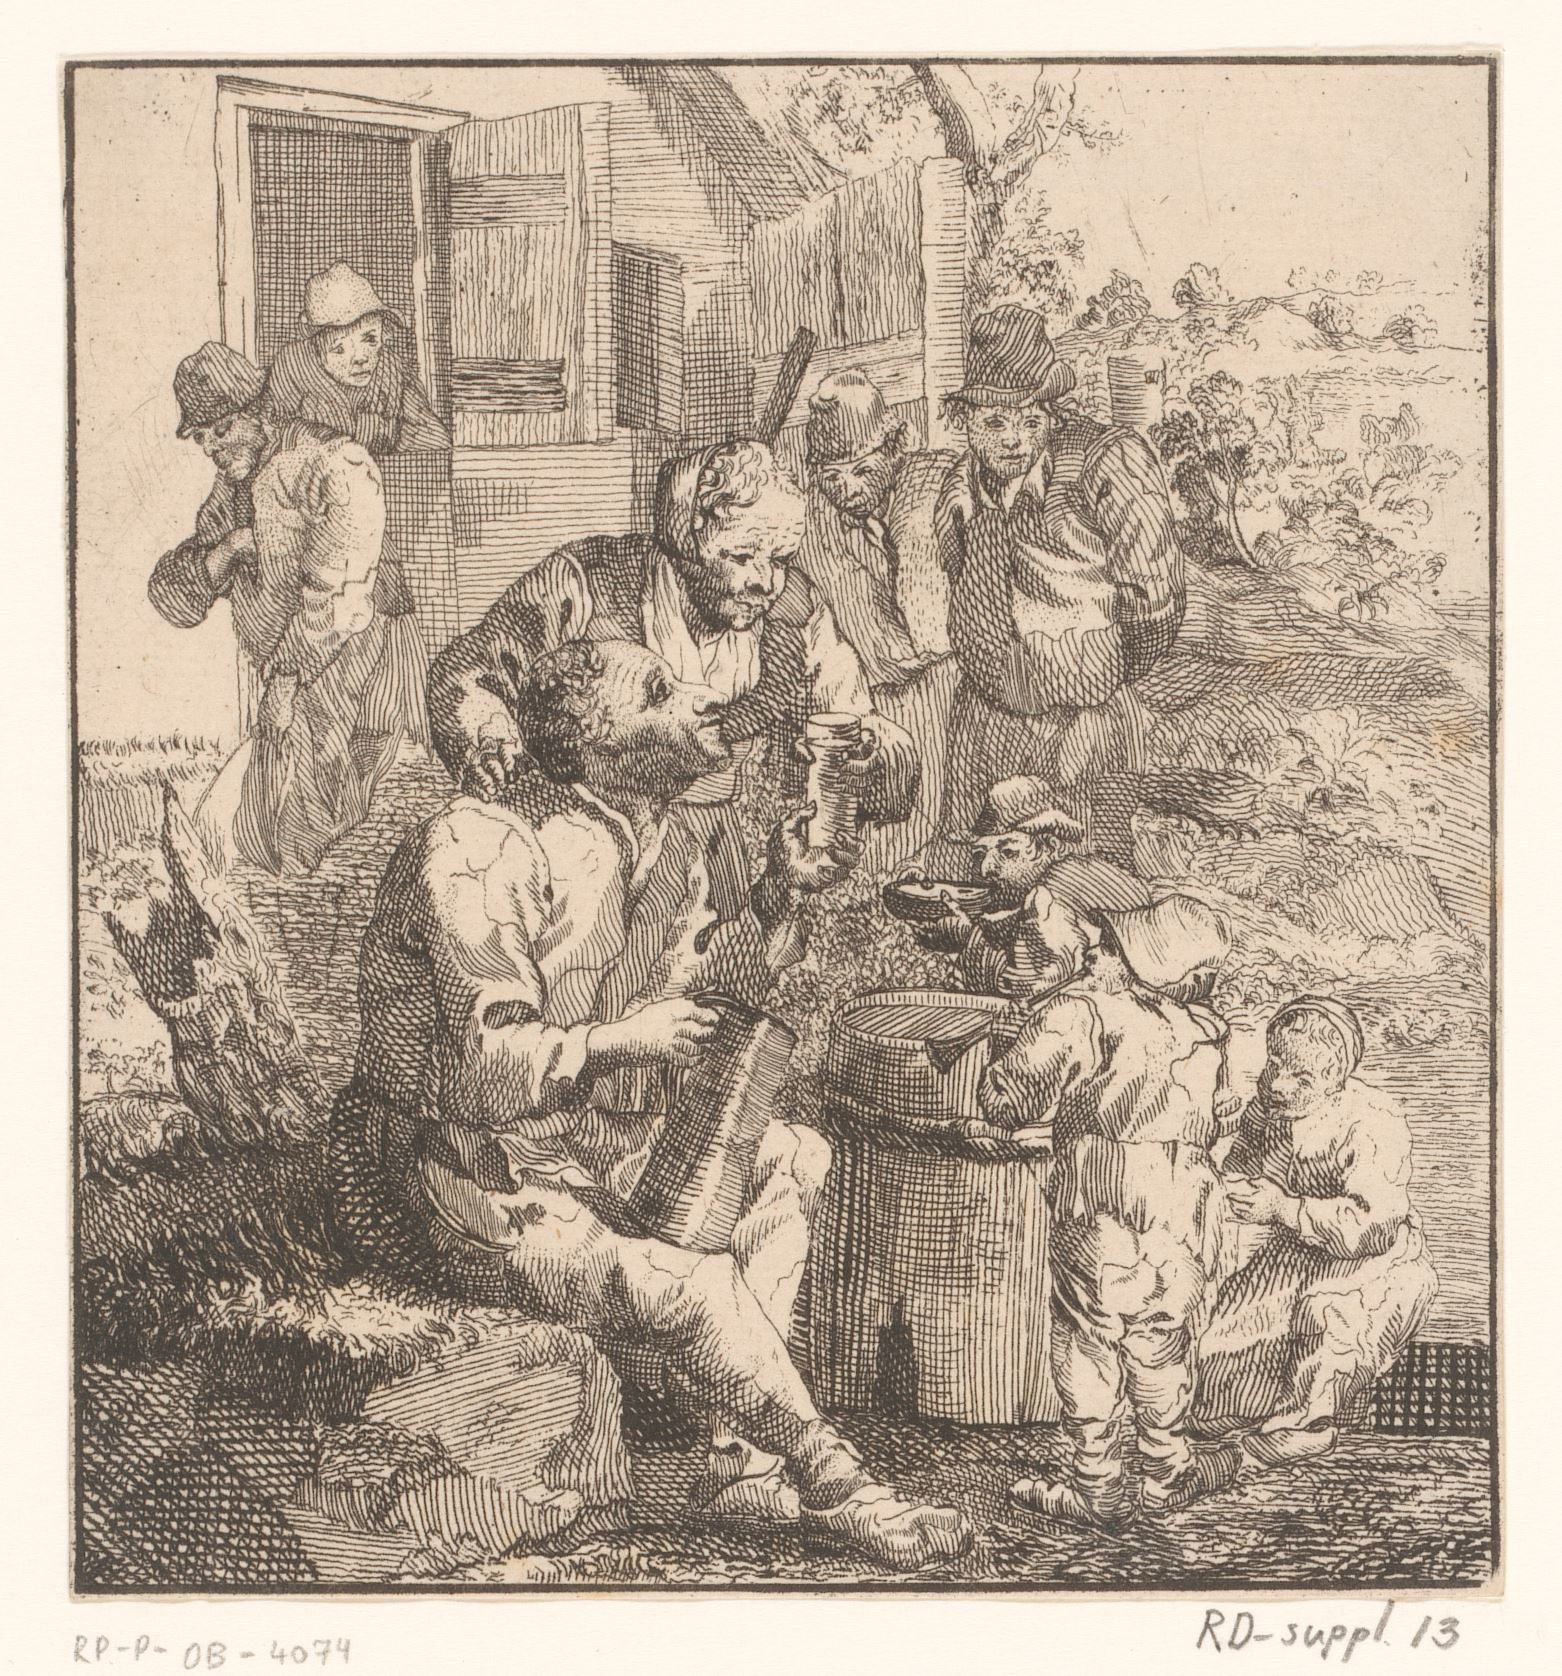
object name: print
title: Negen figuren aan de ingang van een huis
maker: jacques dassonville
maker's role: print maker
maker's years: 1619-1670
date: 1629-1670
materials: paper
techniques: engraving, etching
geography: france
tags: sitting figure, gate, entrance, beer, ale